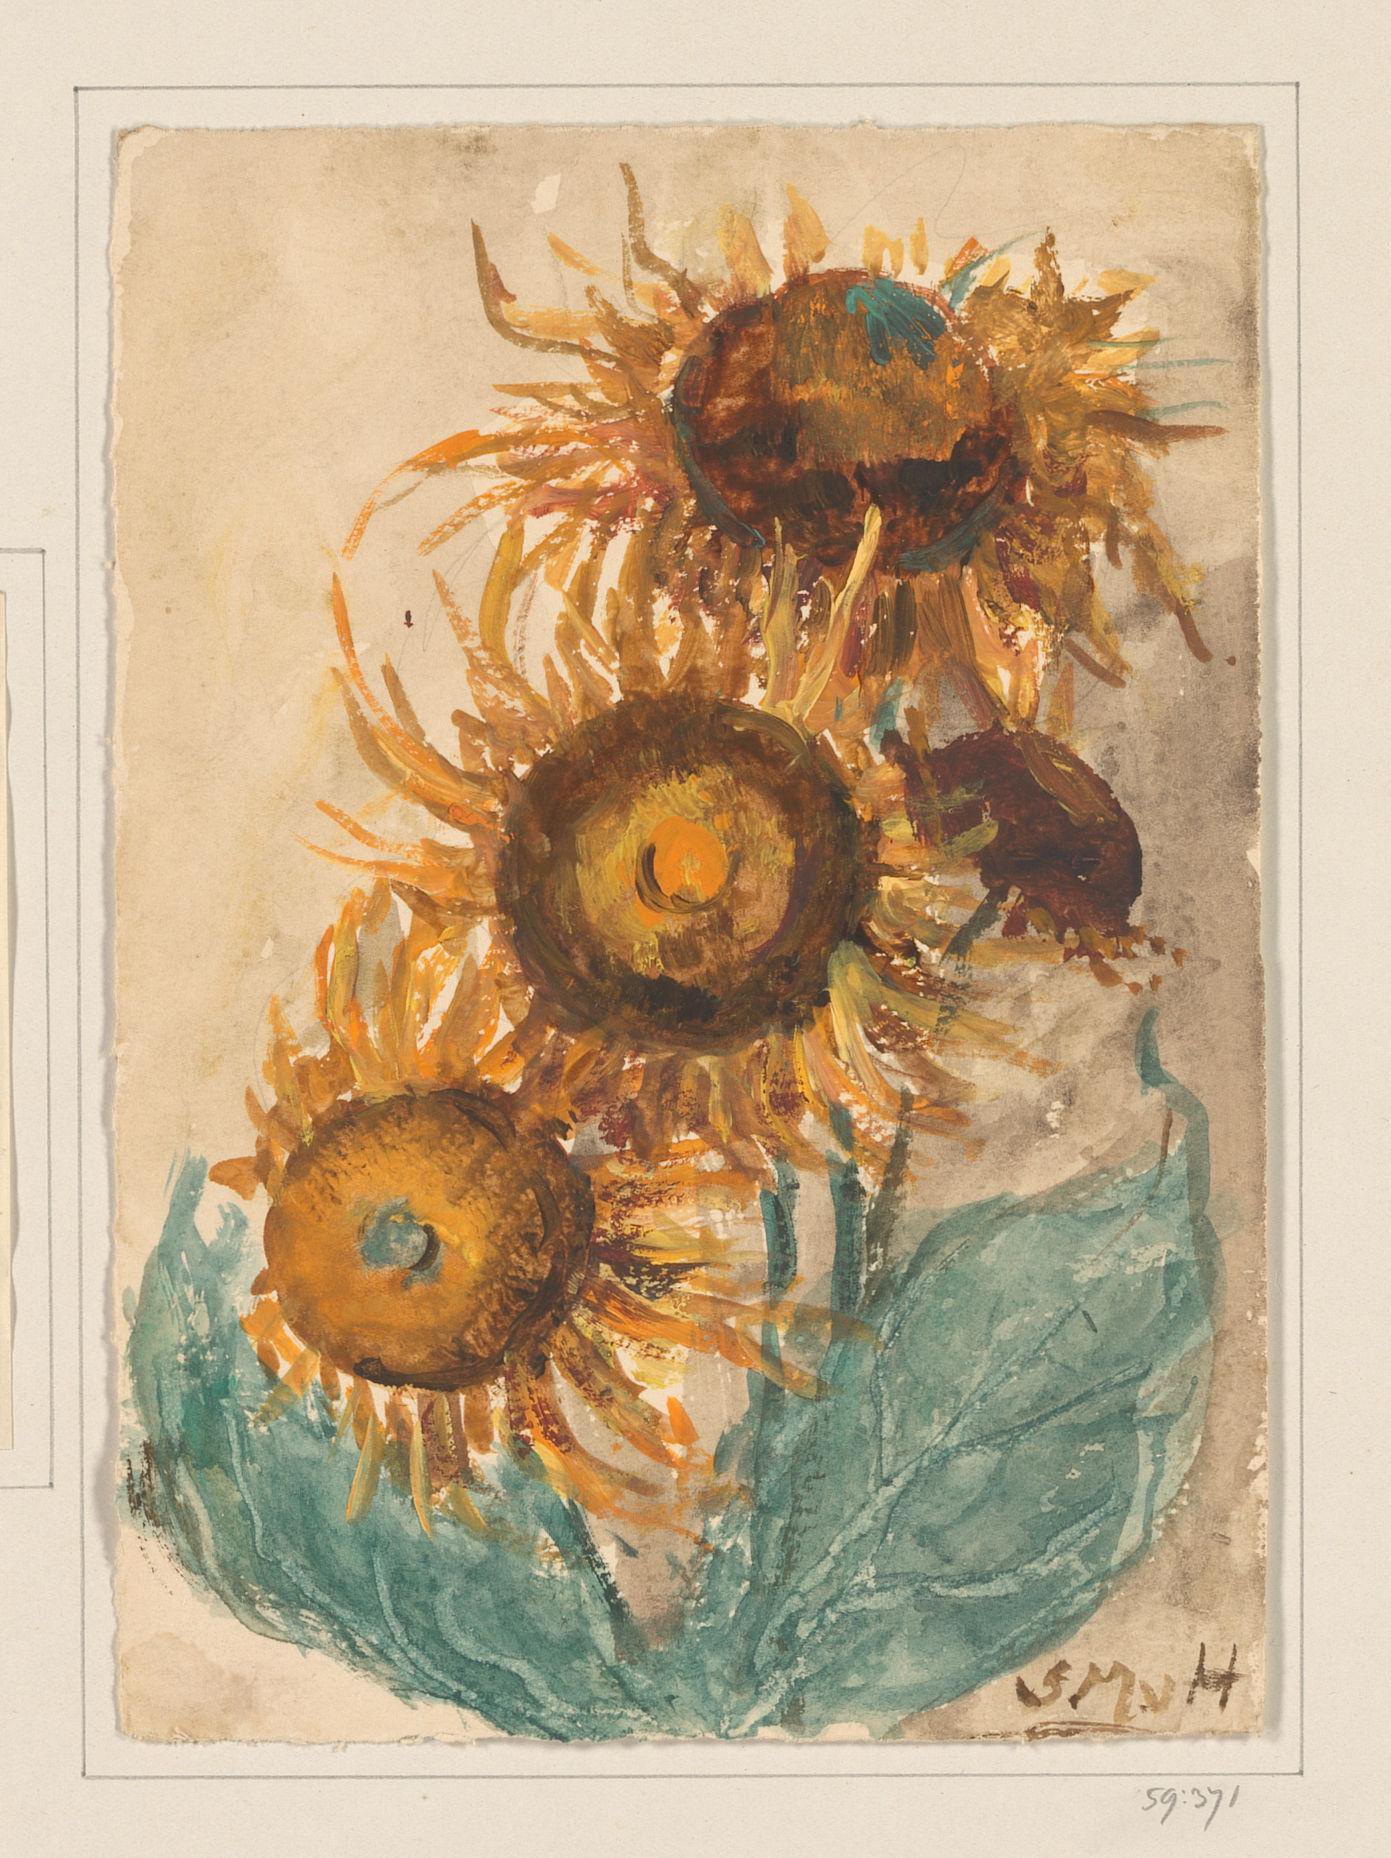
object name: drawing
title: Zonnebloemen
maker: sientje mesdag-van houten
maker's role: draughtsman, painter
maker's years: 1834-1909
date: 1856-1909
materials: paper, pencil, watercolor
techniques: brush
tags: flowers: sunflower